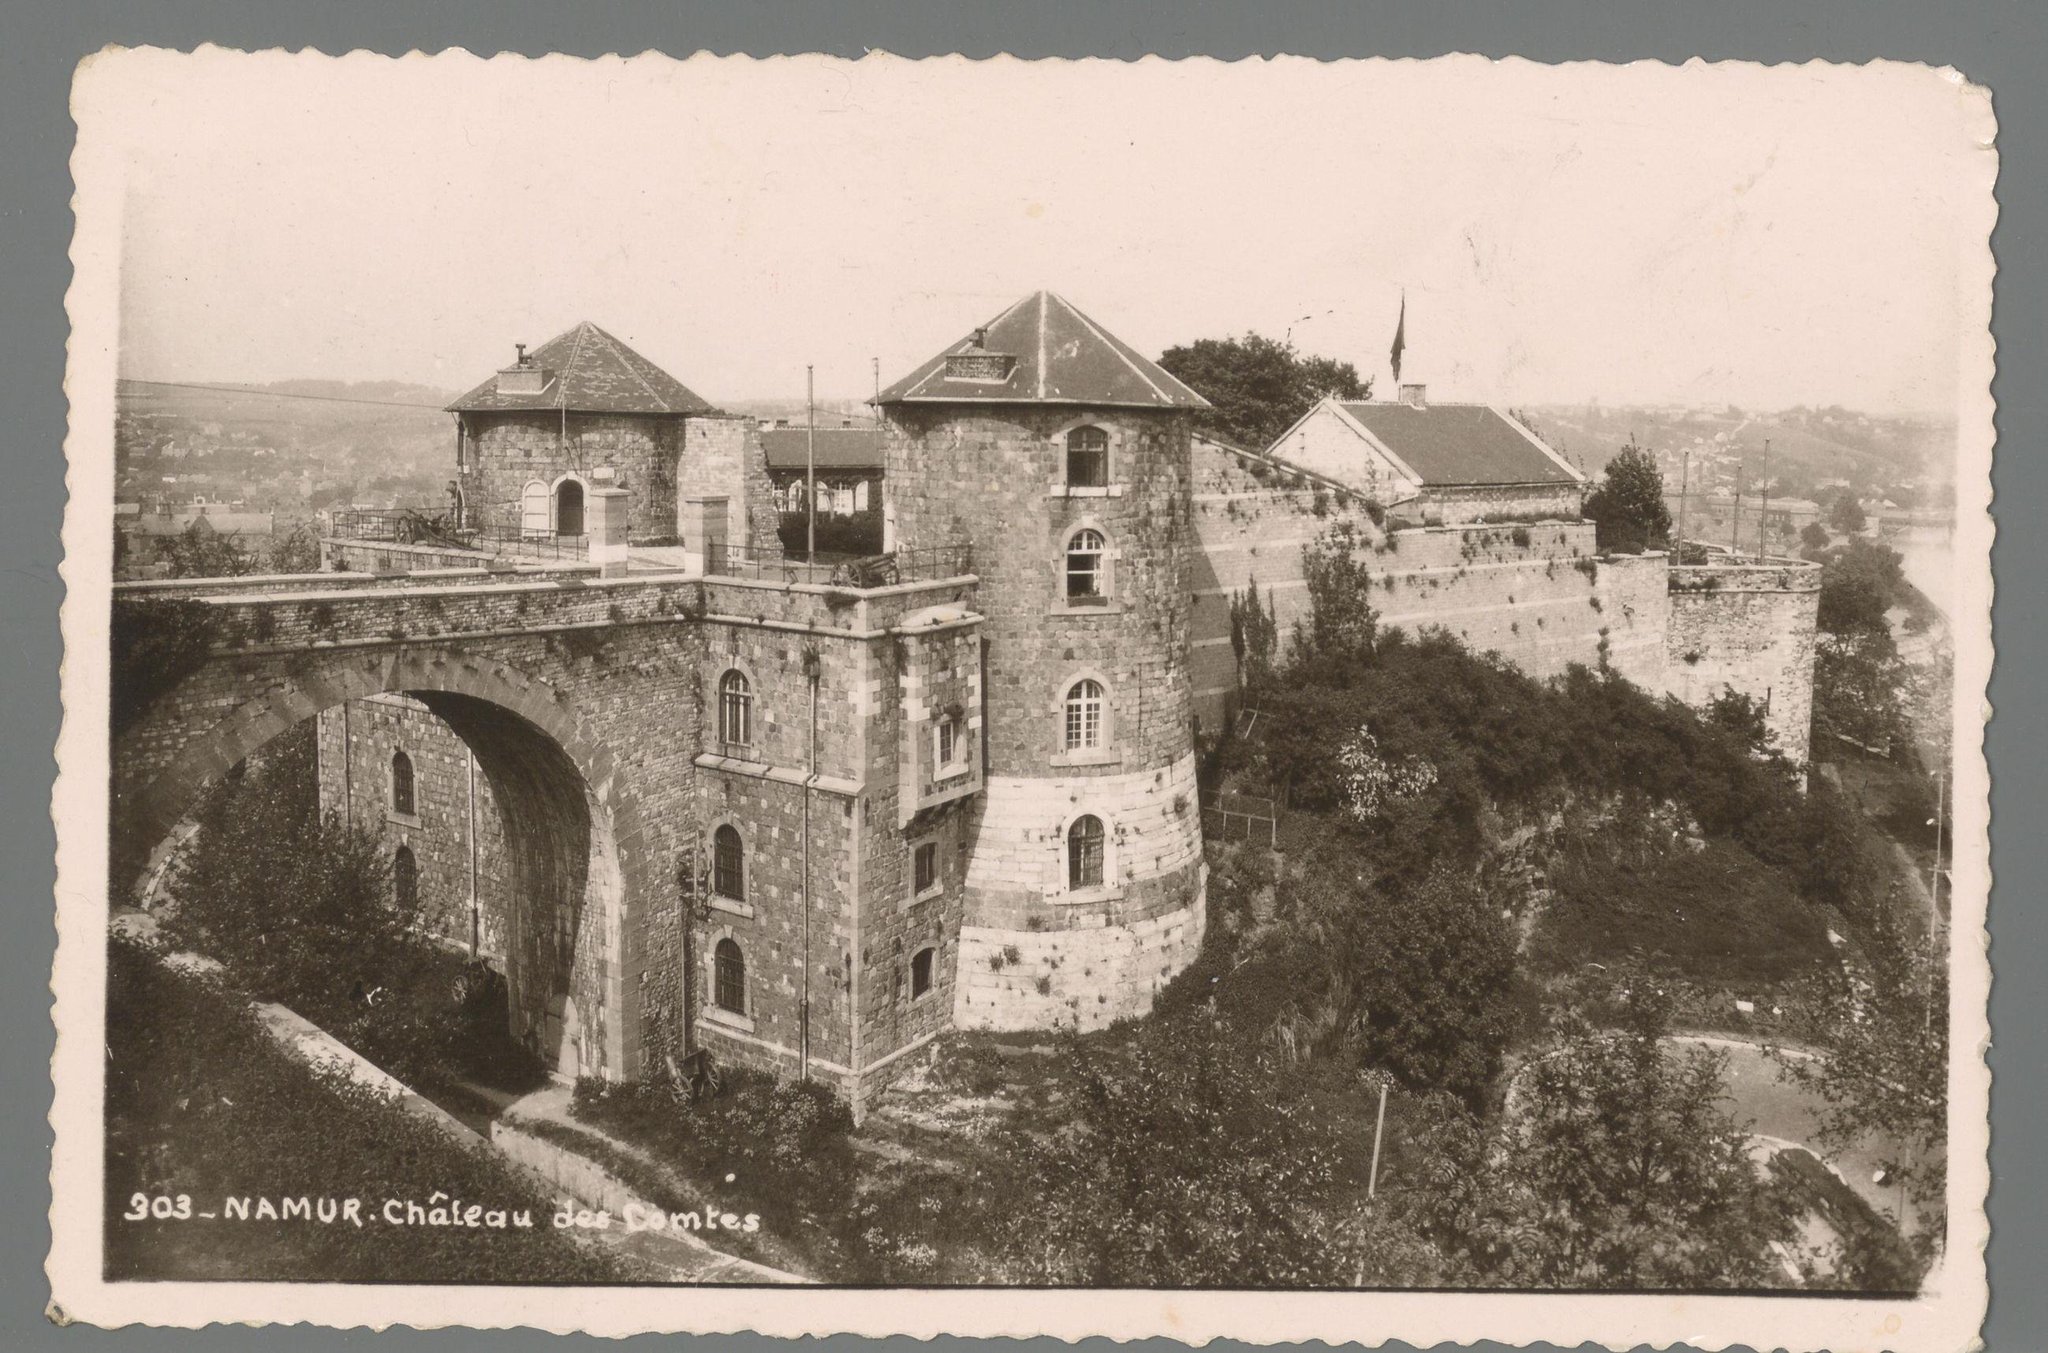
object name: ansichtkaart, prentbriefkaart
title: Namur. Château des Comtes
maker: Anonymous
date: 1935-1960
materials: photographic support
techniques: photography, writing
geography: namur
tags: castle, bridge, prospect of city, town panorama, silhouette of city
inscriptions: poststempel, verso, gestempeld